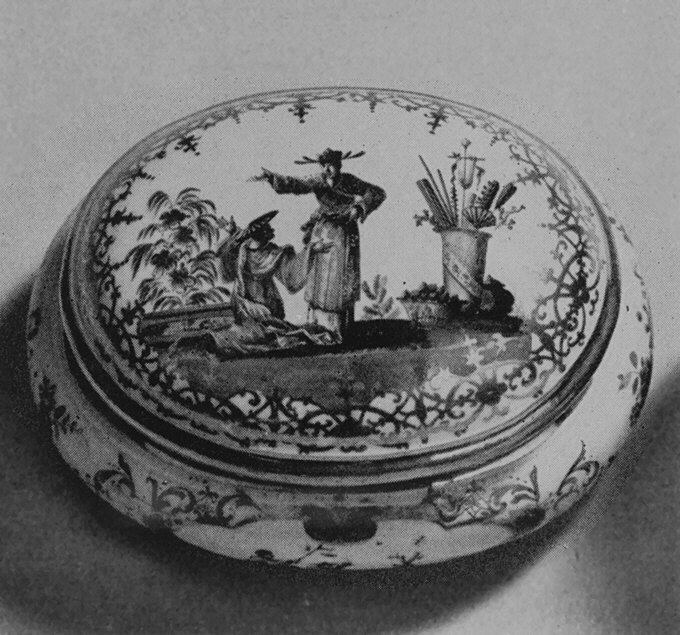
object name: sugar box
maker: meissen manufactory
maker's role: manufactory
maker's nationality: german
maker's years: 1710-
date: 1723-1724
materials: hard paste porcelain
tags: men,plants